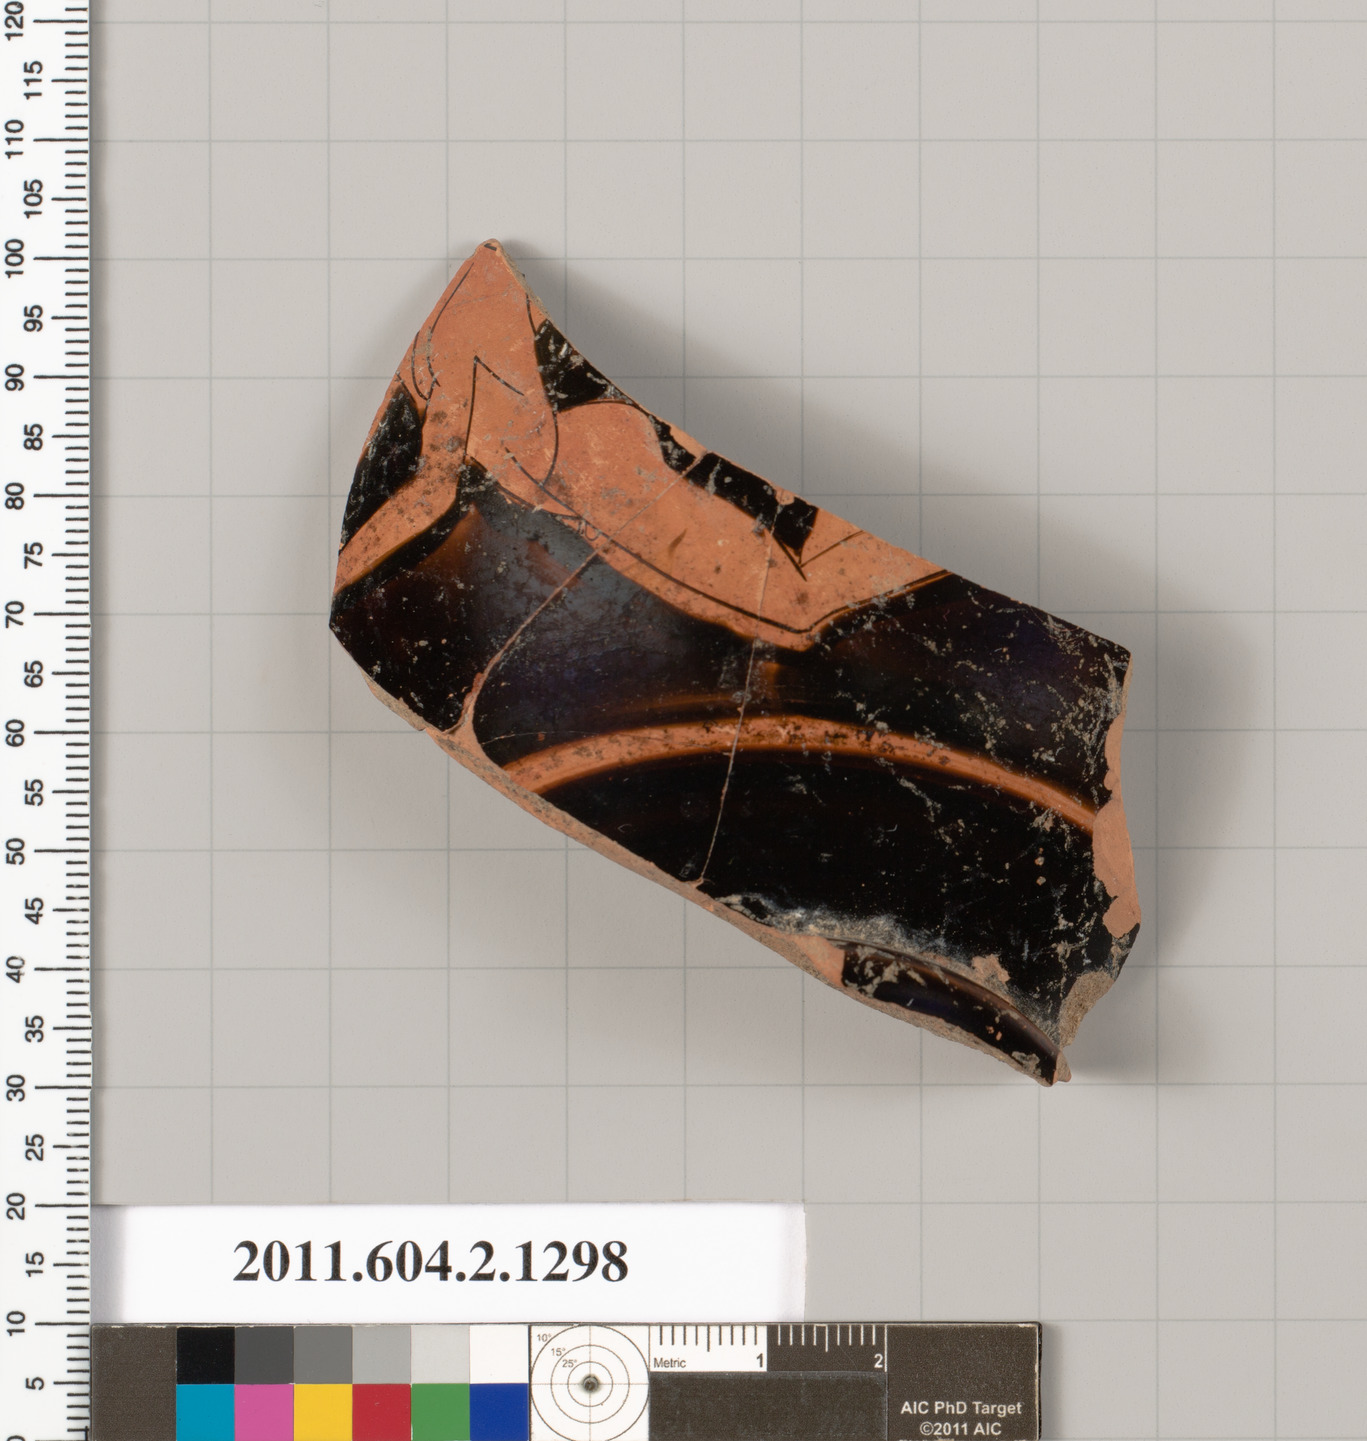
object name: skyphos fragment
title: Terracotta fragment of a skyphos (deep drinking cup)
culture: greek, attic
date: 475-451 BCE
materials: terracotta